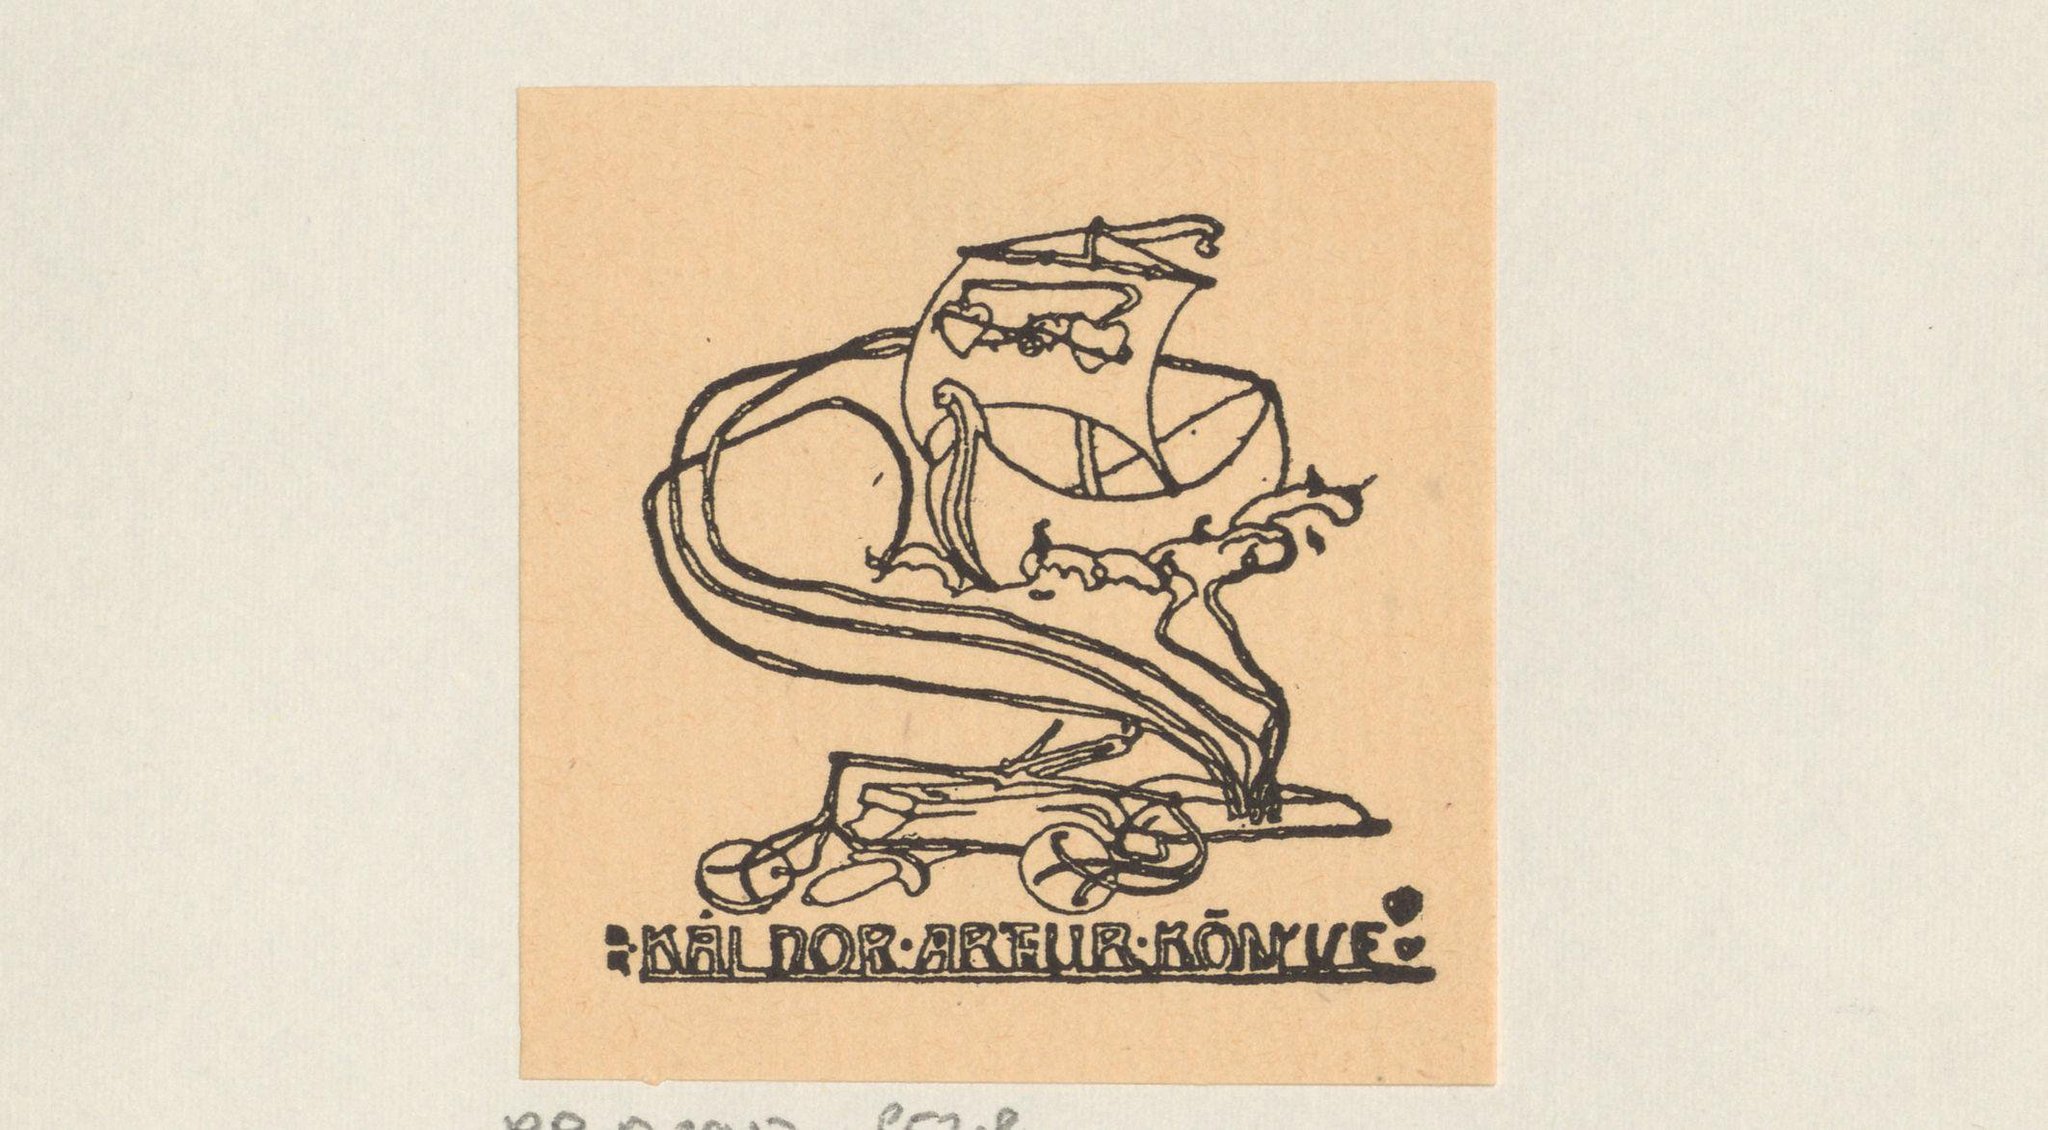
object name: bookplate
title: Káldor Artur Konyve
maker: Anonymous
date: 1905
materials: paper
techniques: printing block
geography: hungary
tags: sailing-ship, sailing-boat, weighing-instruments